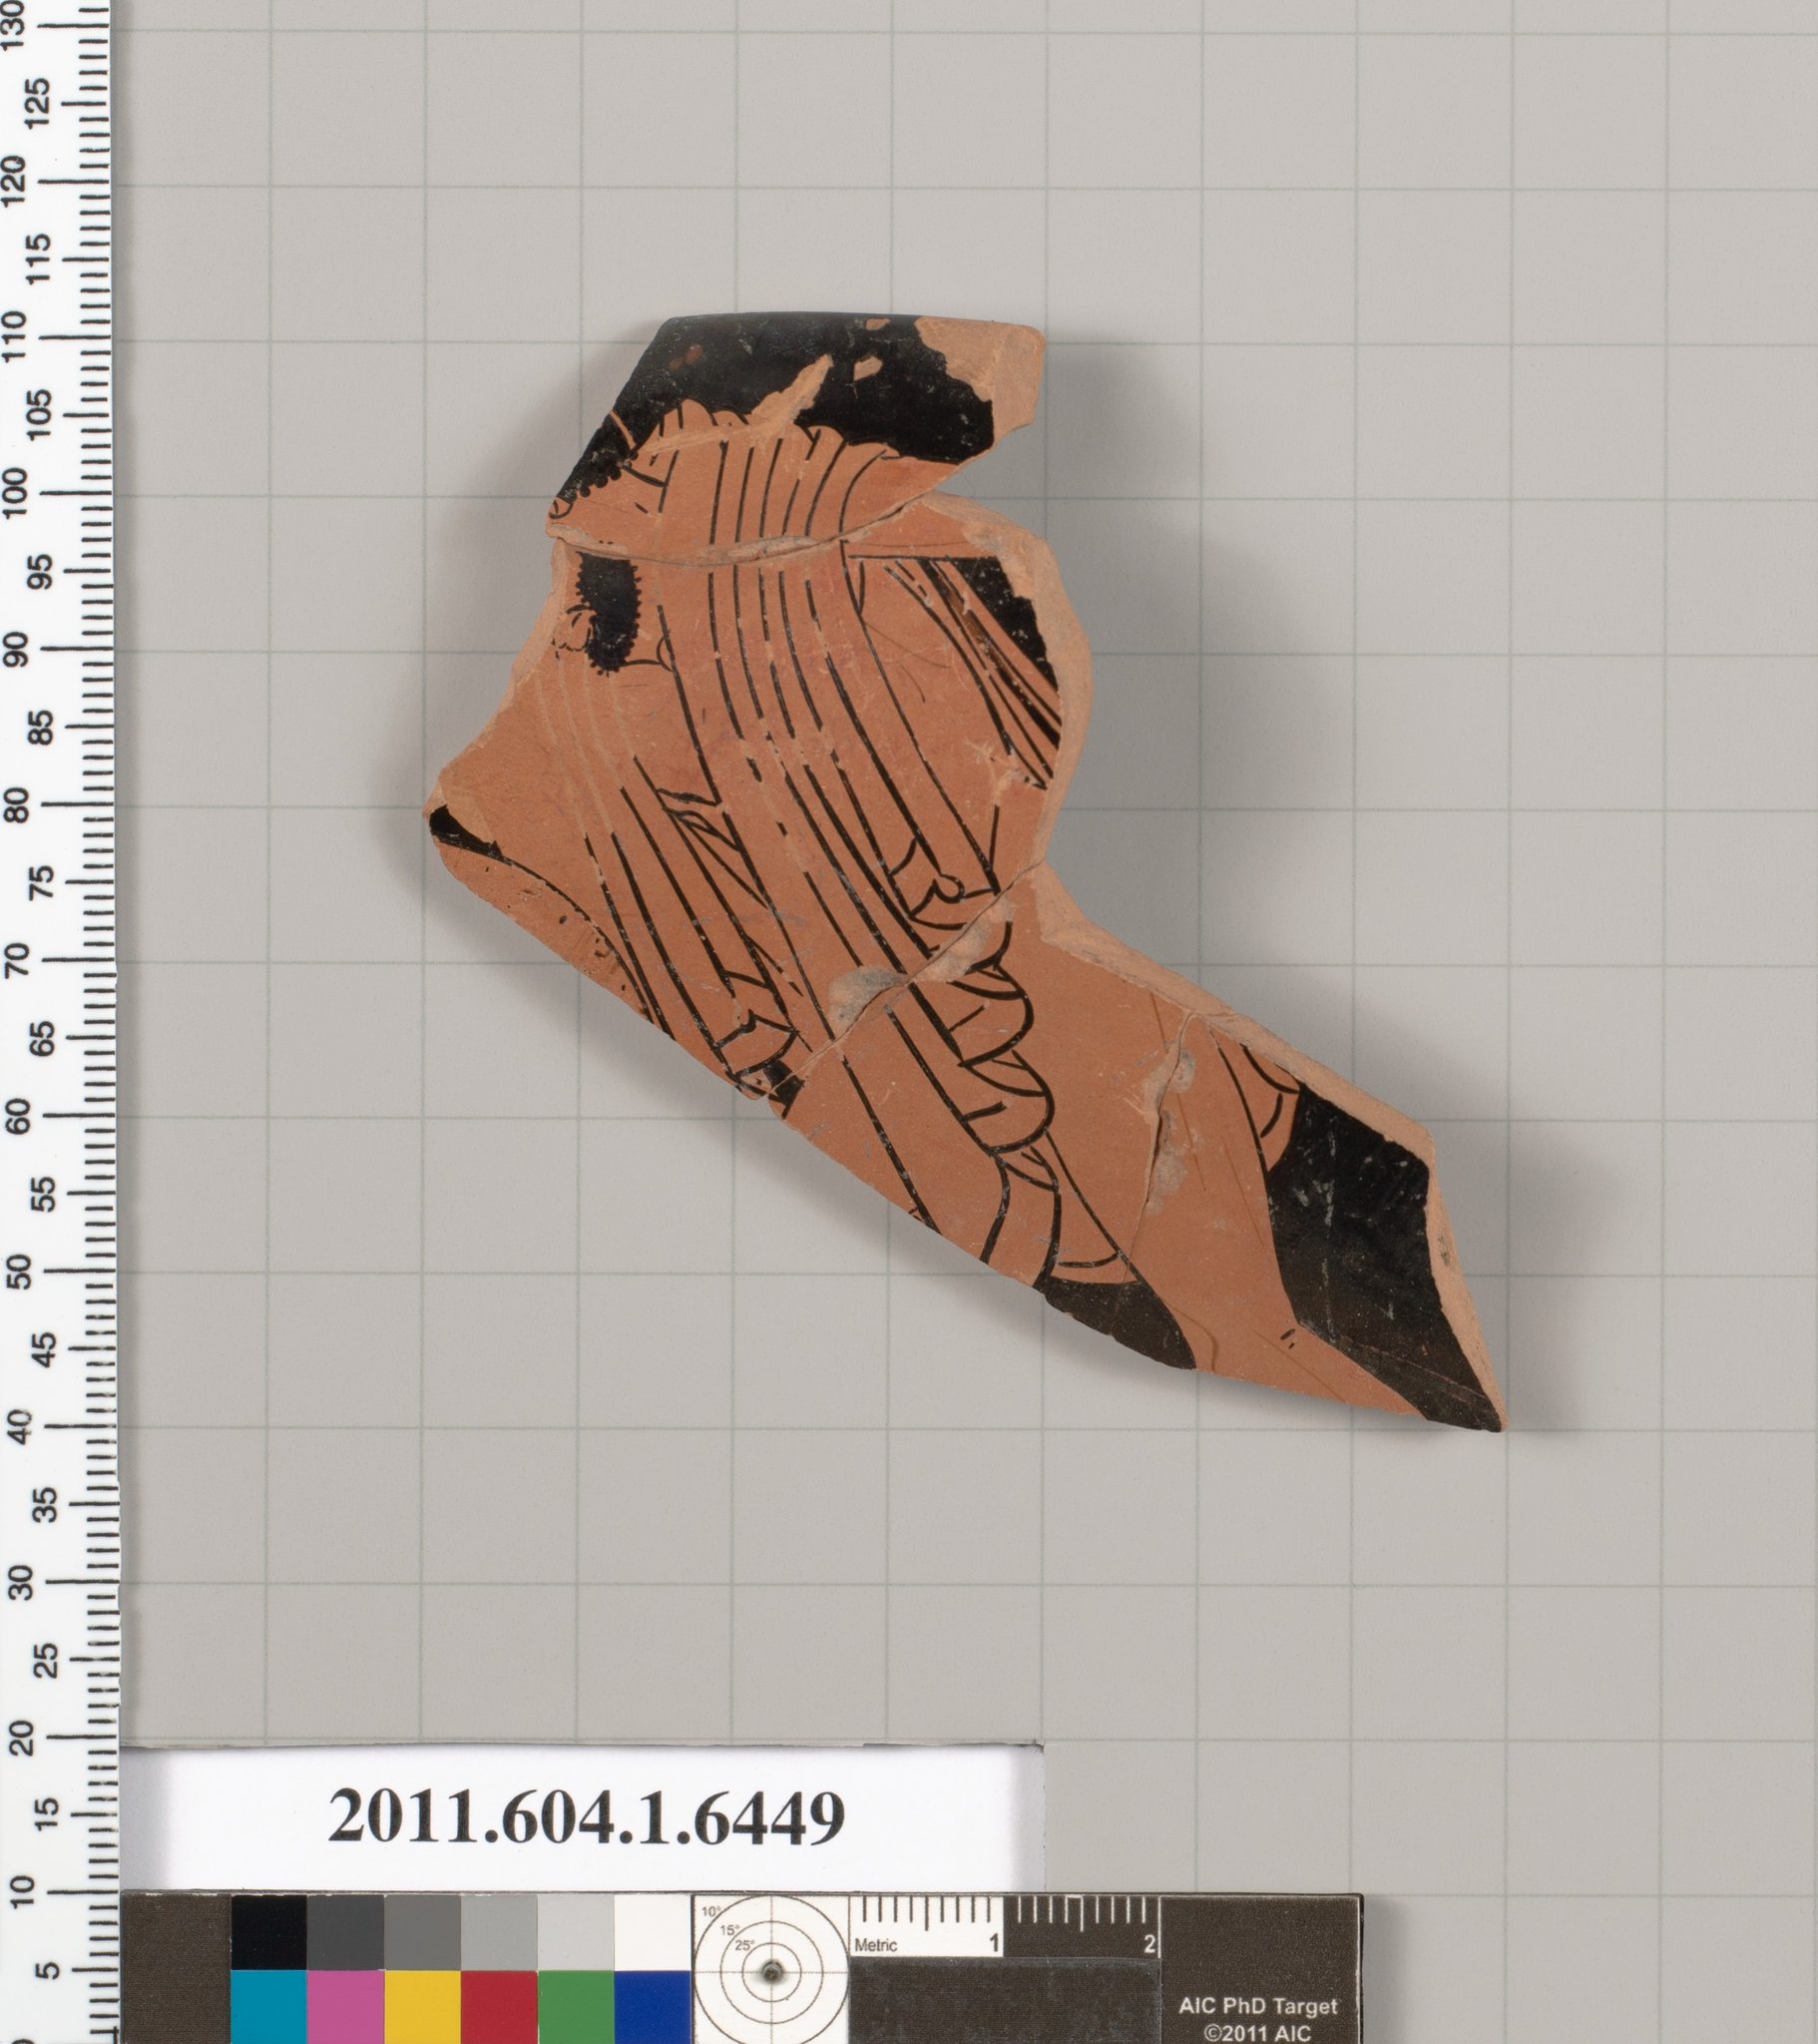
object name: kylix fragment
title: Terracotta rim fragment of a kylix (drinking cup)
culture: greek, attic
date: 490-480 BCE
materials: terracotta